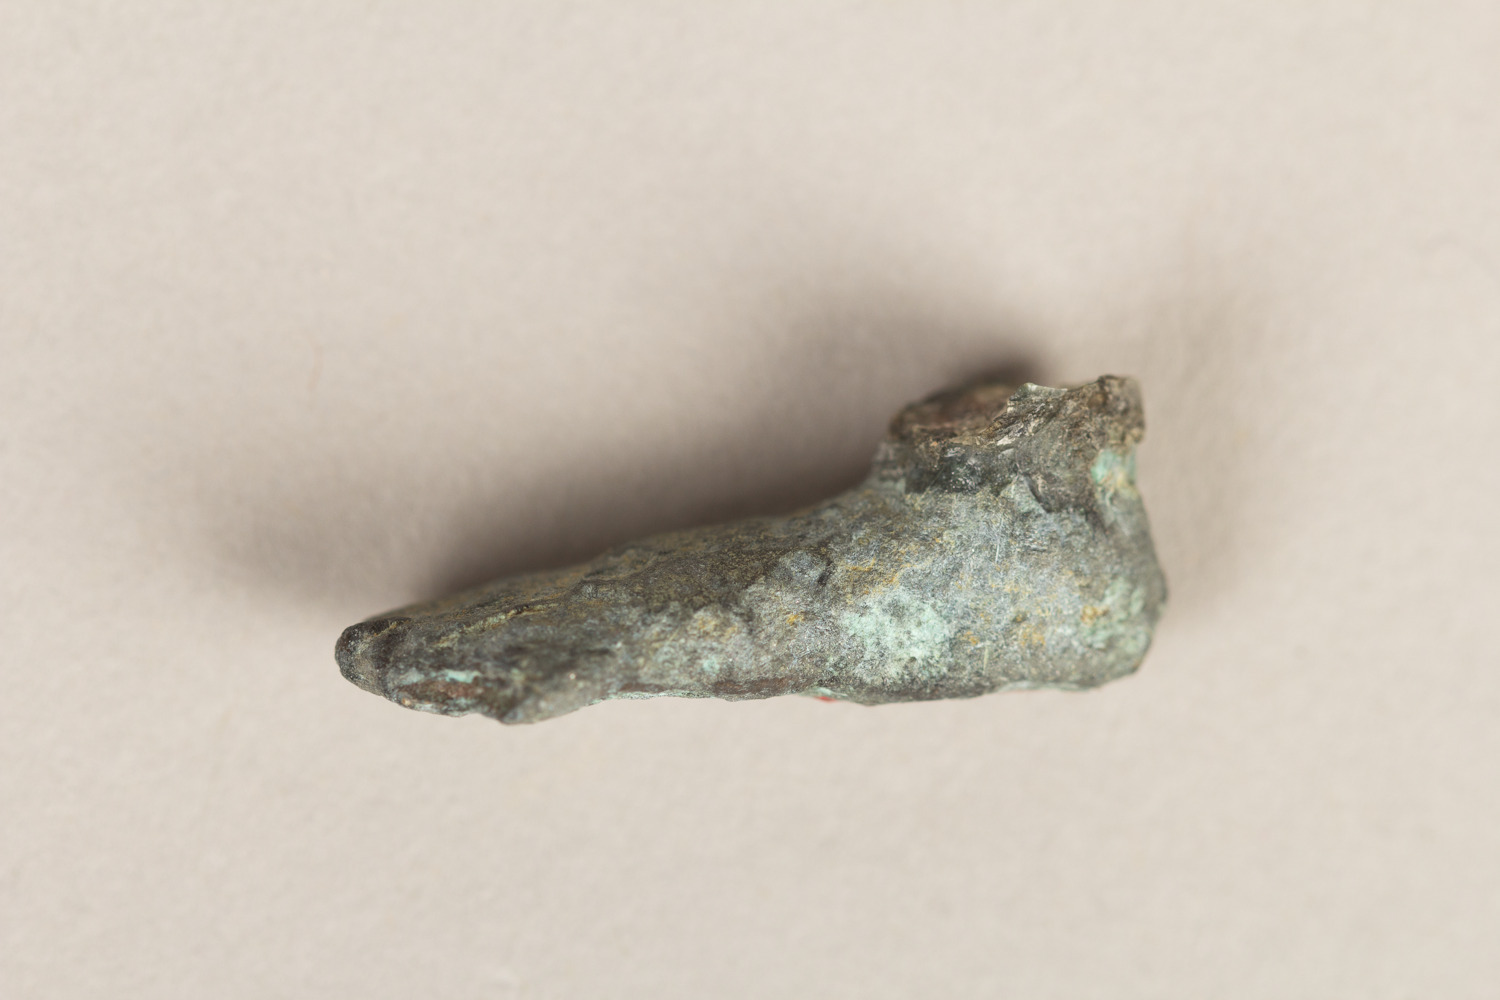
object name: figure fragment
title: Fragment of a Foot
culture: indonesian, kalimantan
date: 701-800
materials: bronze